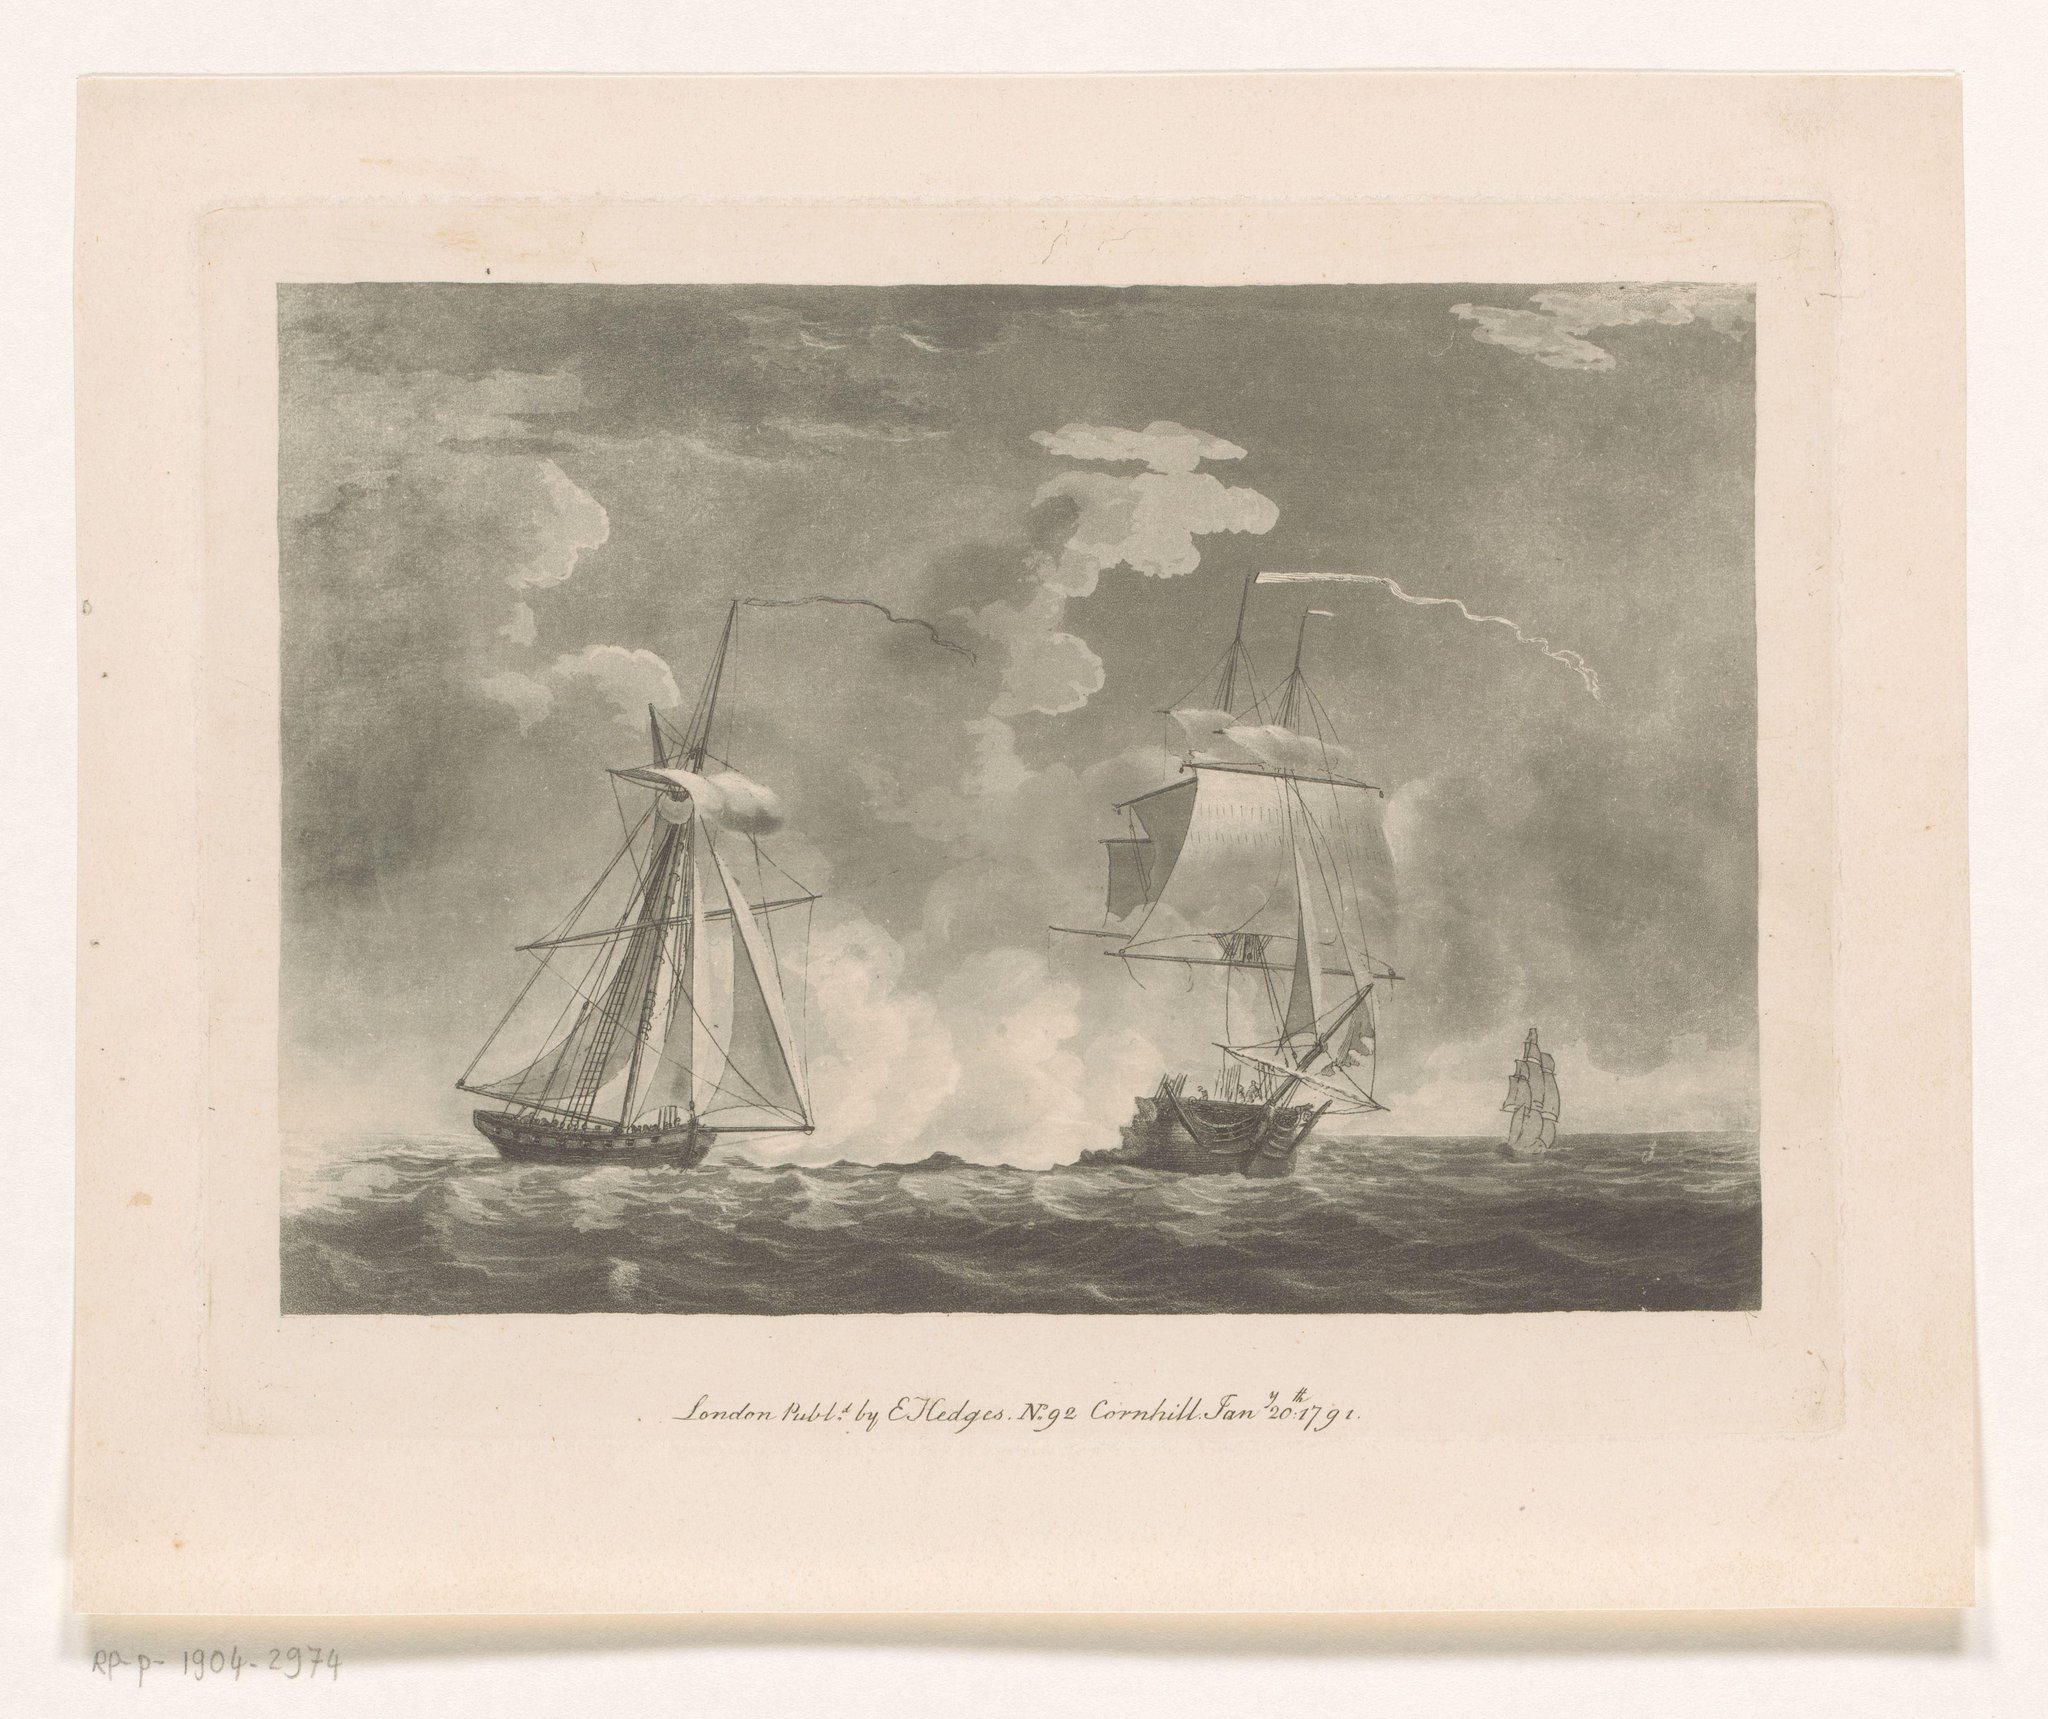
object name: print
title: Zeegezichten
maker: edward hedges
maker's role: publisher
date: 1791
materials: paper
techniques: etching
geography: london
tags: ships (in general), mist, fog, sea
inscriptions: collector's mark: Lugt 2228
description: Deze prent maakt deel uit van een serie van vier prenten.